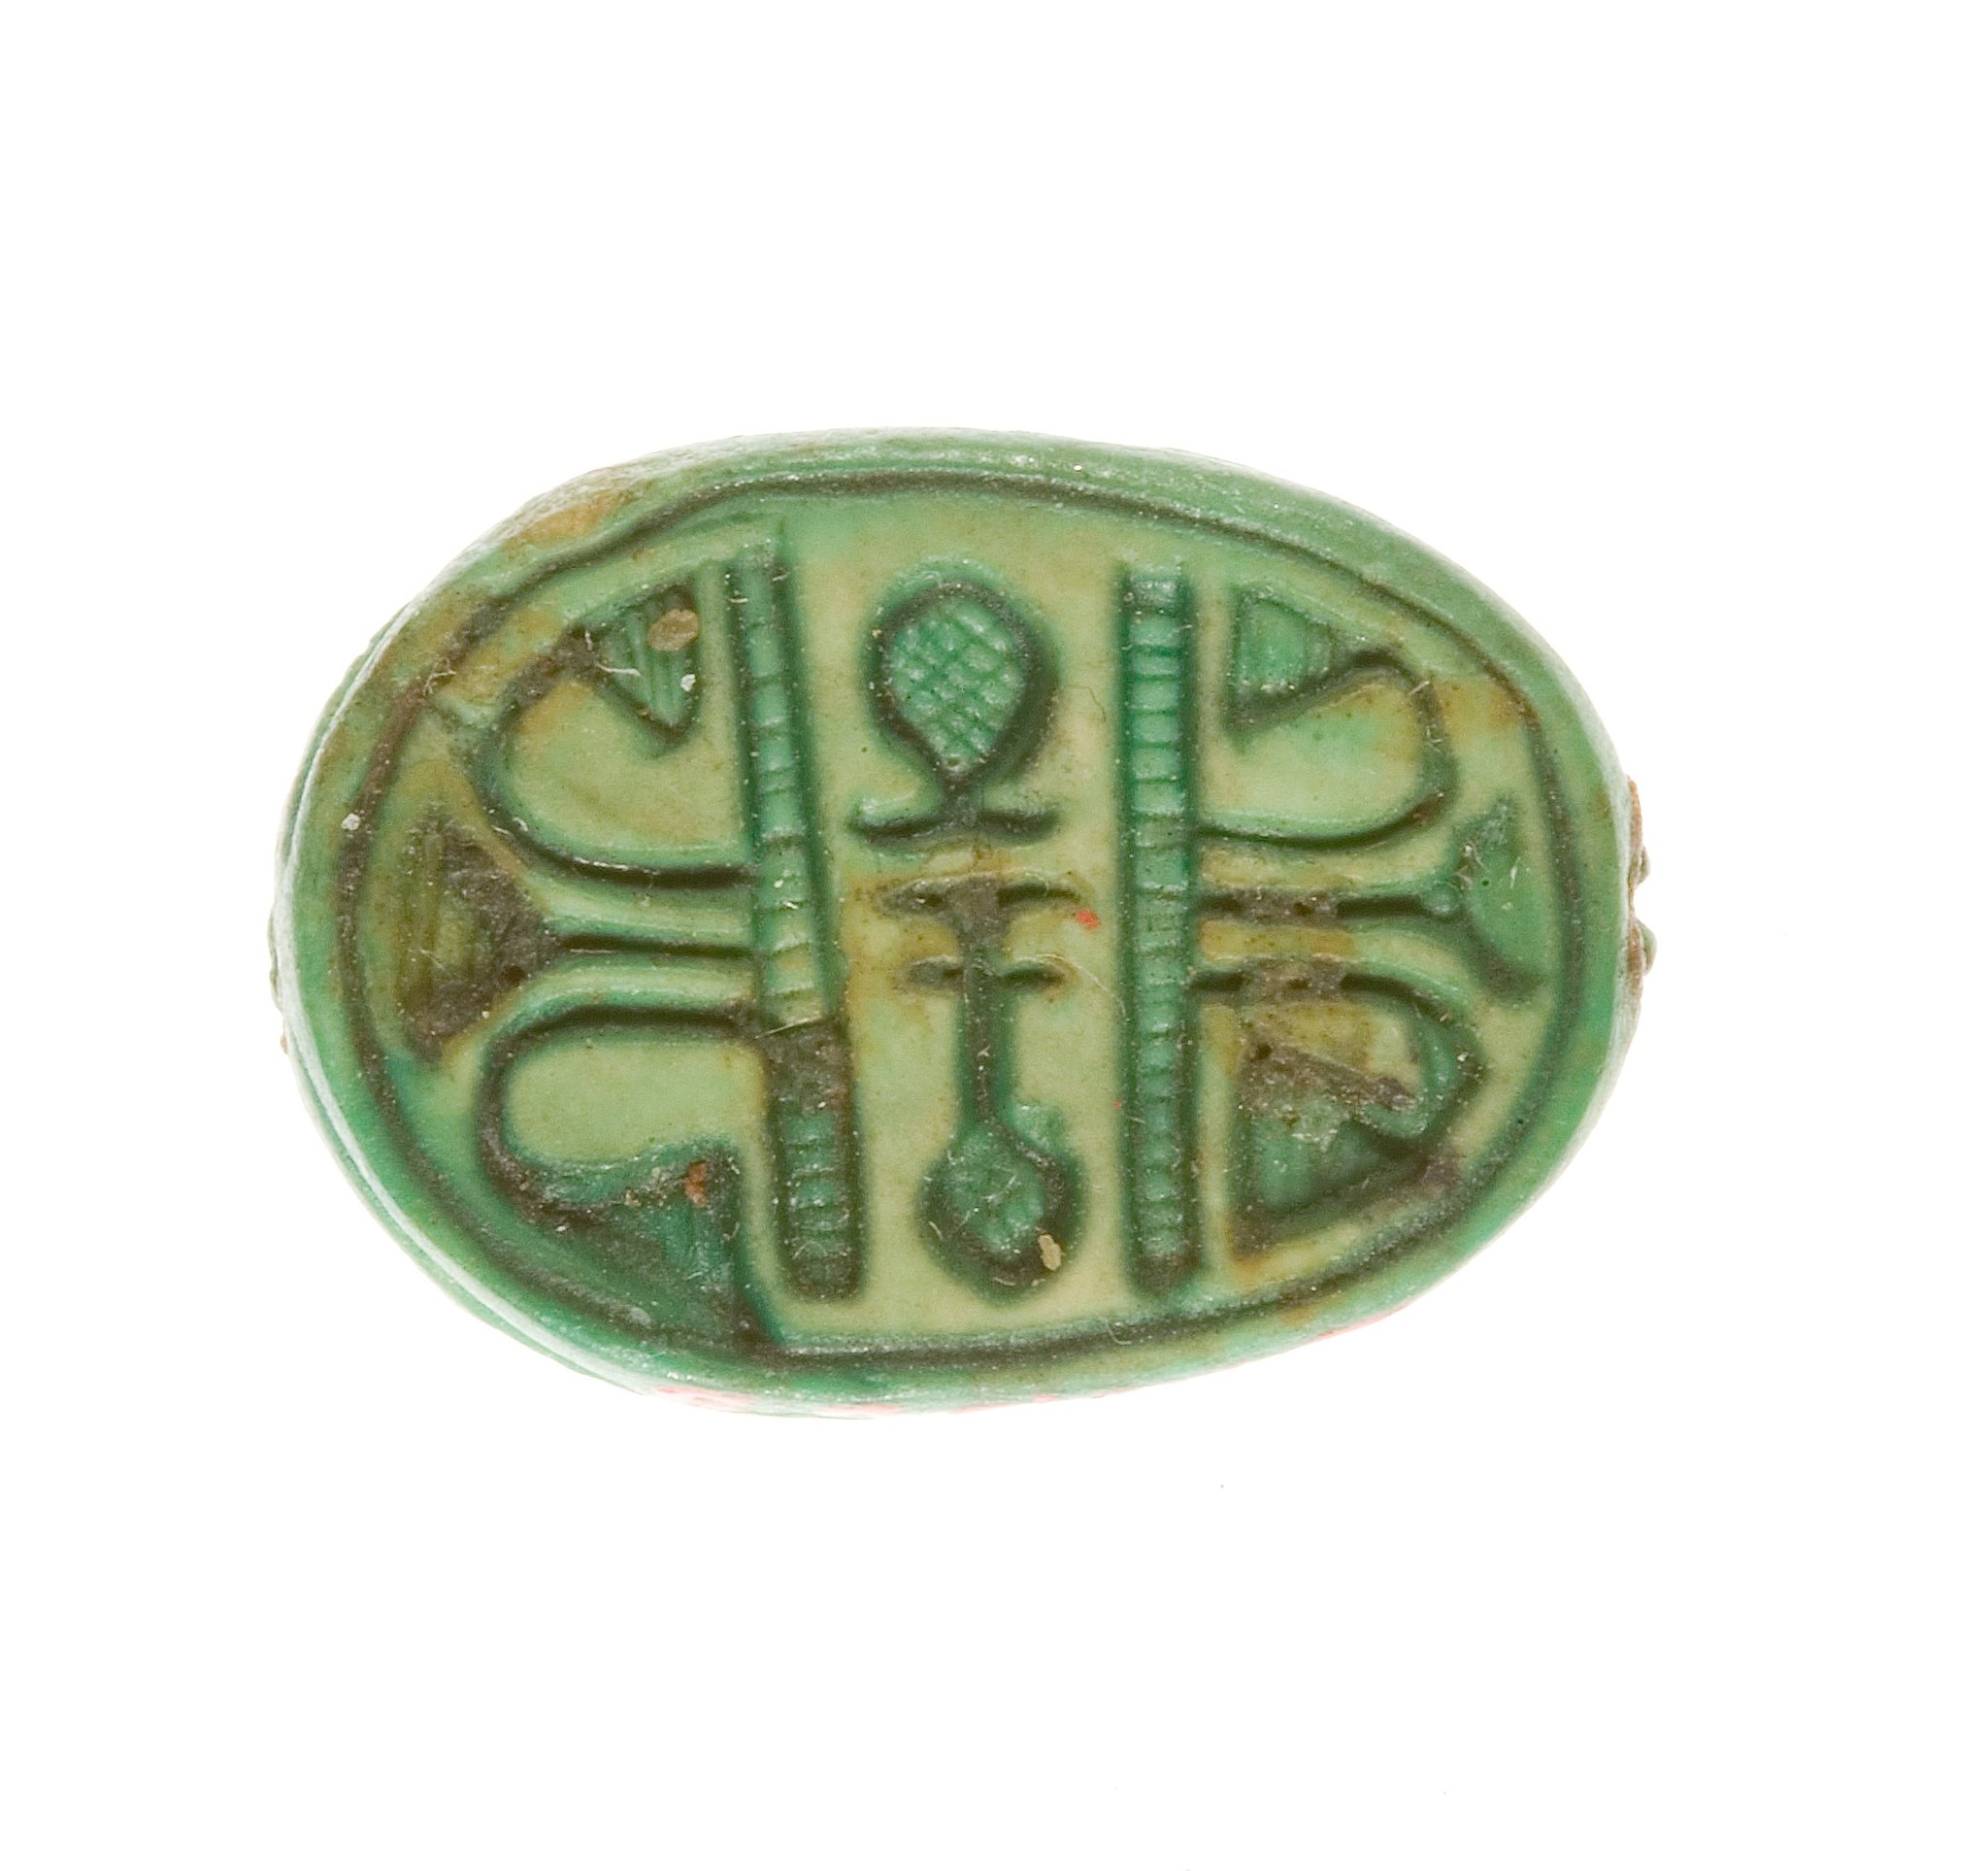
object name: scarab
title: Scarab Inscribed with Plant Motifs and Hieroglyphs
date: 1479-1458 BCE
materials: stone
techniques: glazing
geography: egypt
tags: hieroglyphs,scarabs